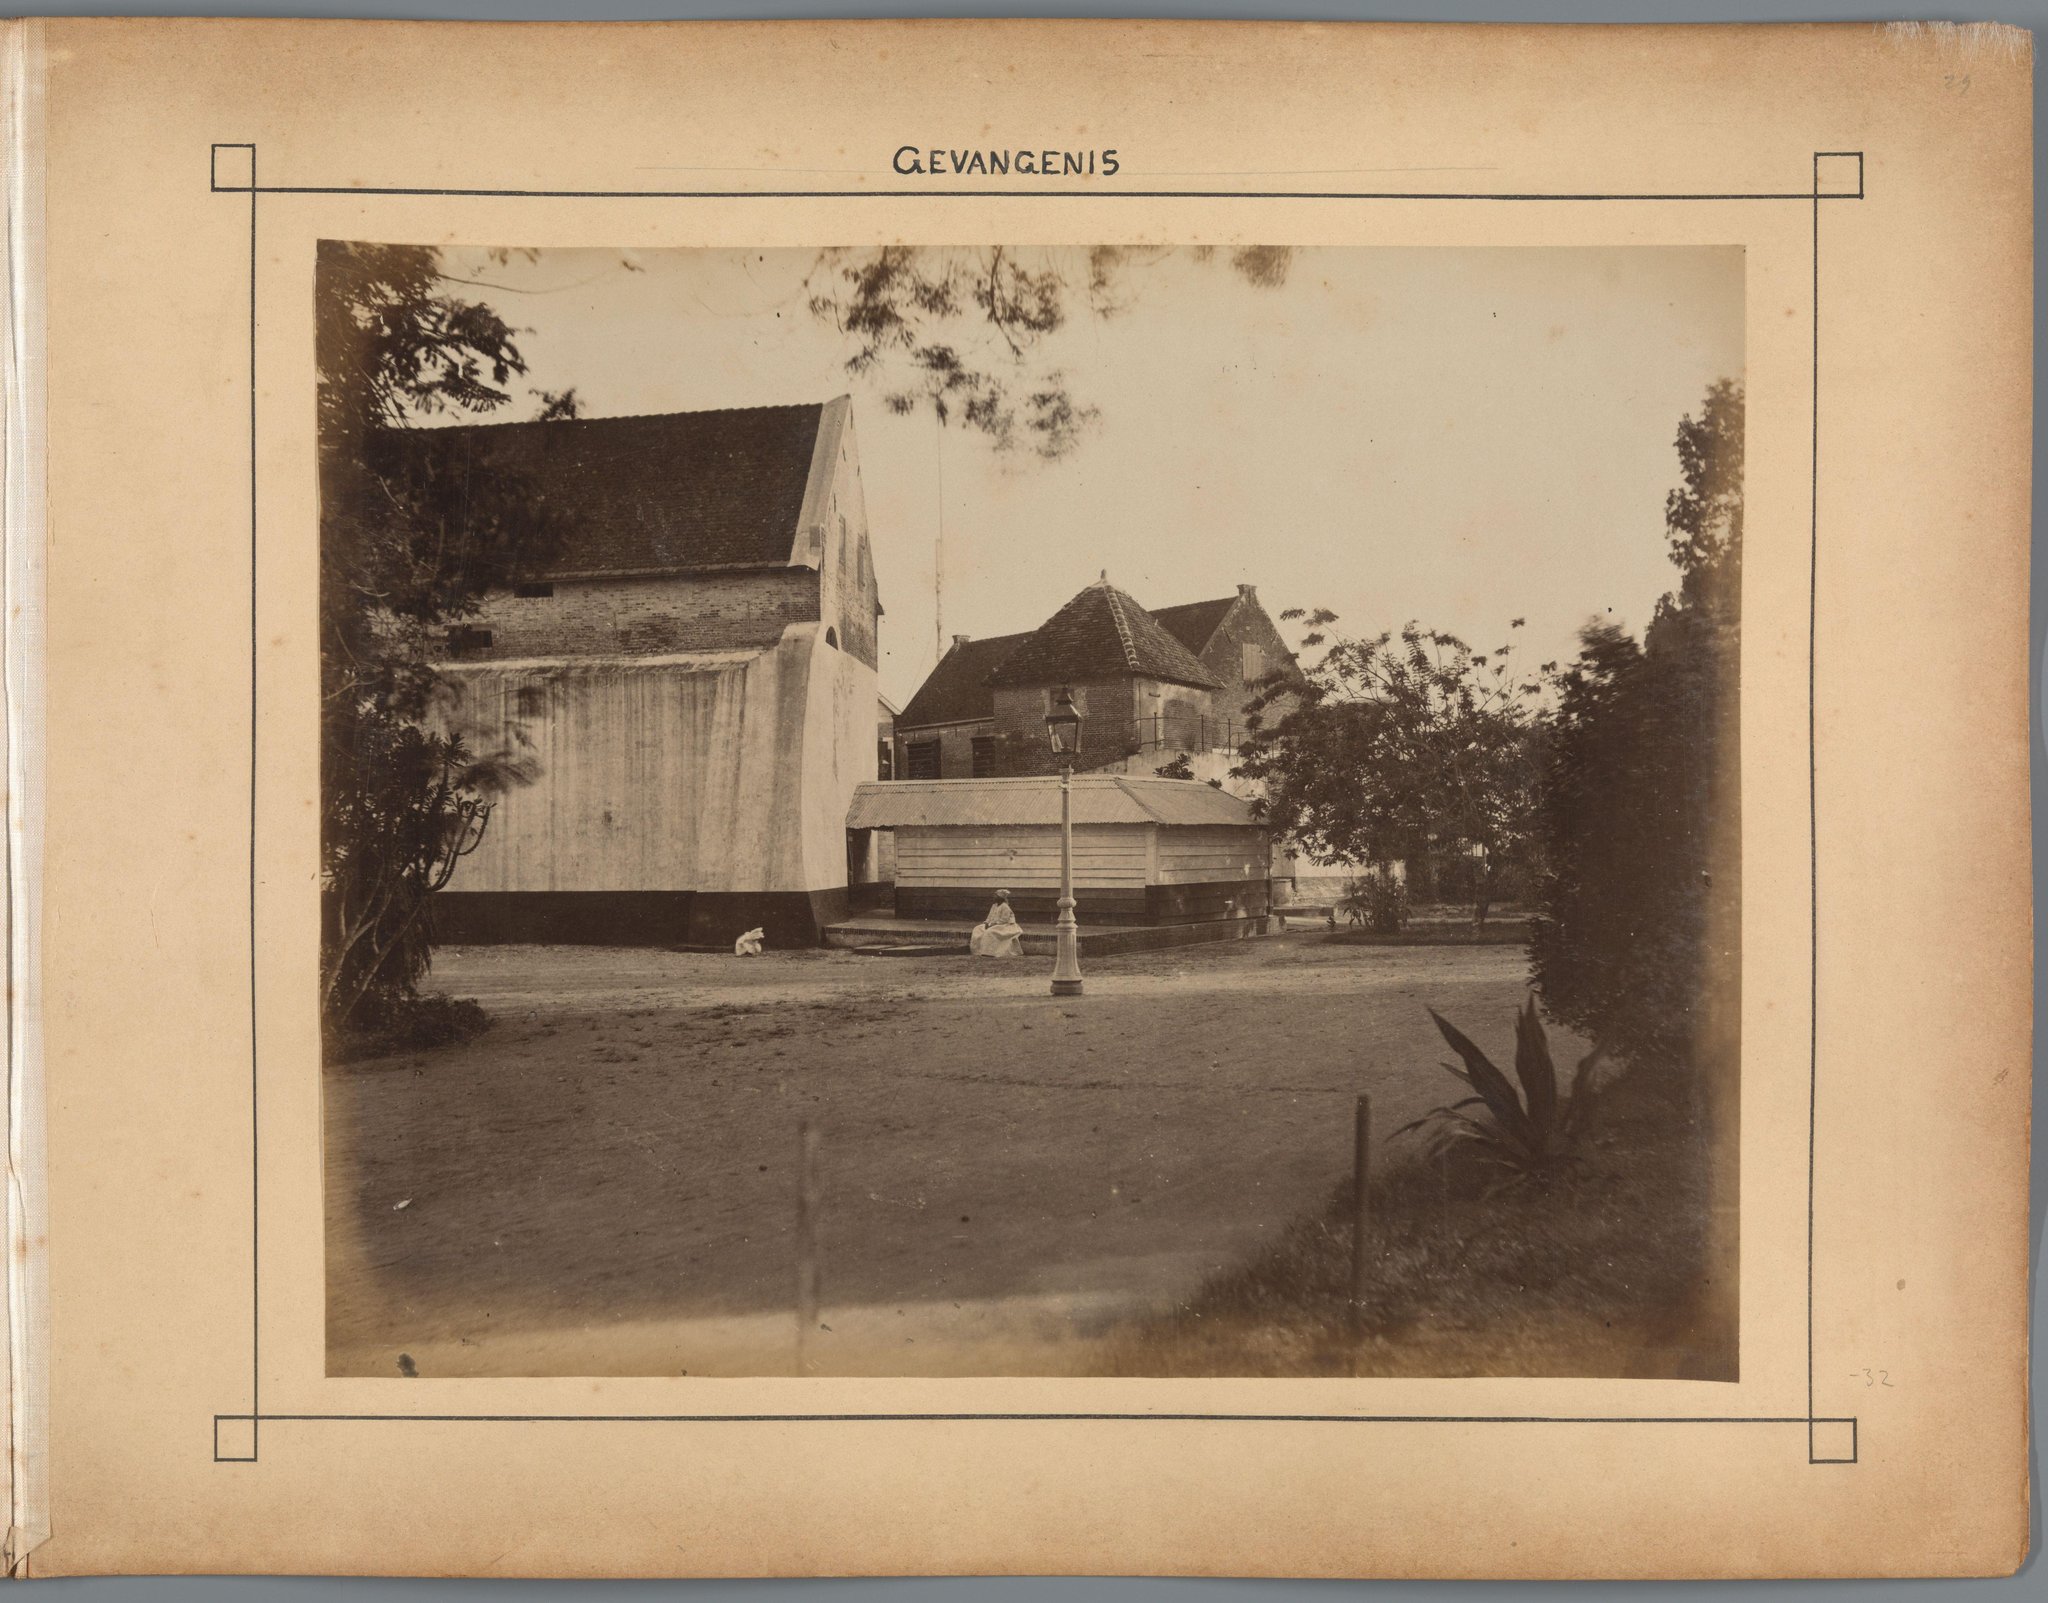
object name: photograph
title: Gevangenis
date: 1898-1902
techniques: albumen print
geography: suriname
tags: prison, jail, suriname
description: De gevangenis op het terrein van Fort Zeelandia, Paramaribo.